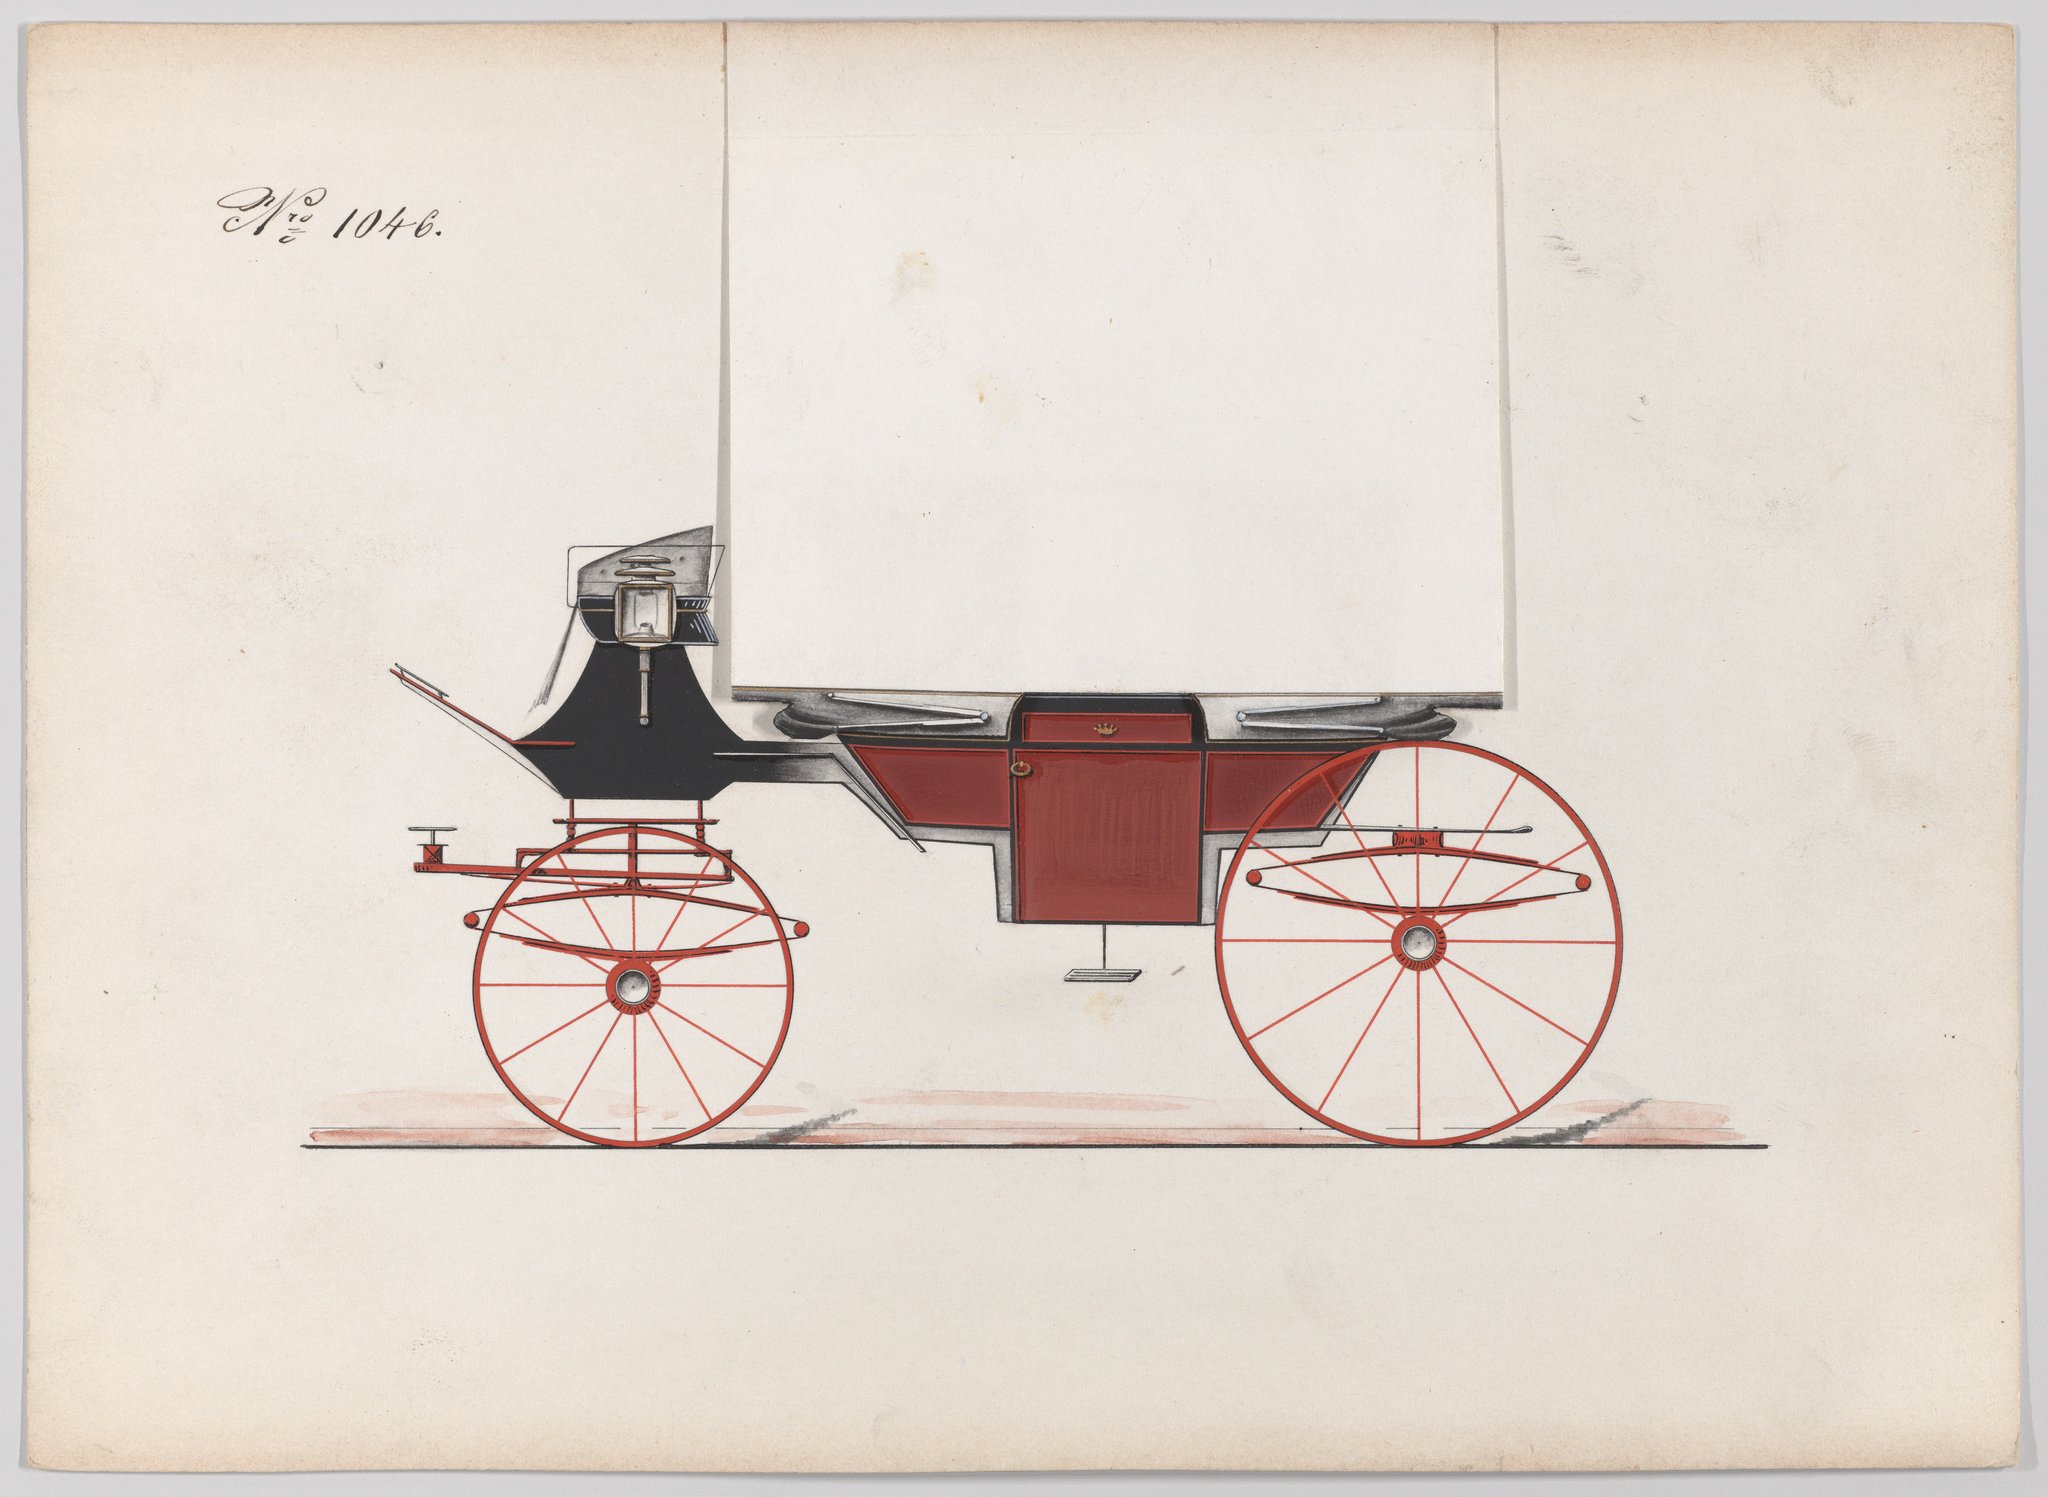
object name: drawing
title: Landau #1046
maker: brewster & co.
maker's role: manufacturer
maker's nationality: american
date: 1850-1870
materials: gouache, gum arabic, ink, watercolor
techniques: pen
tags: carriages